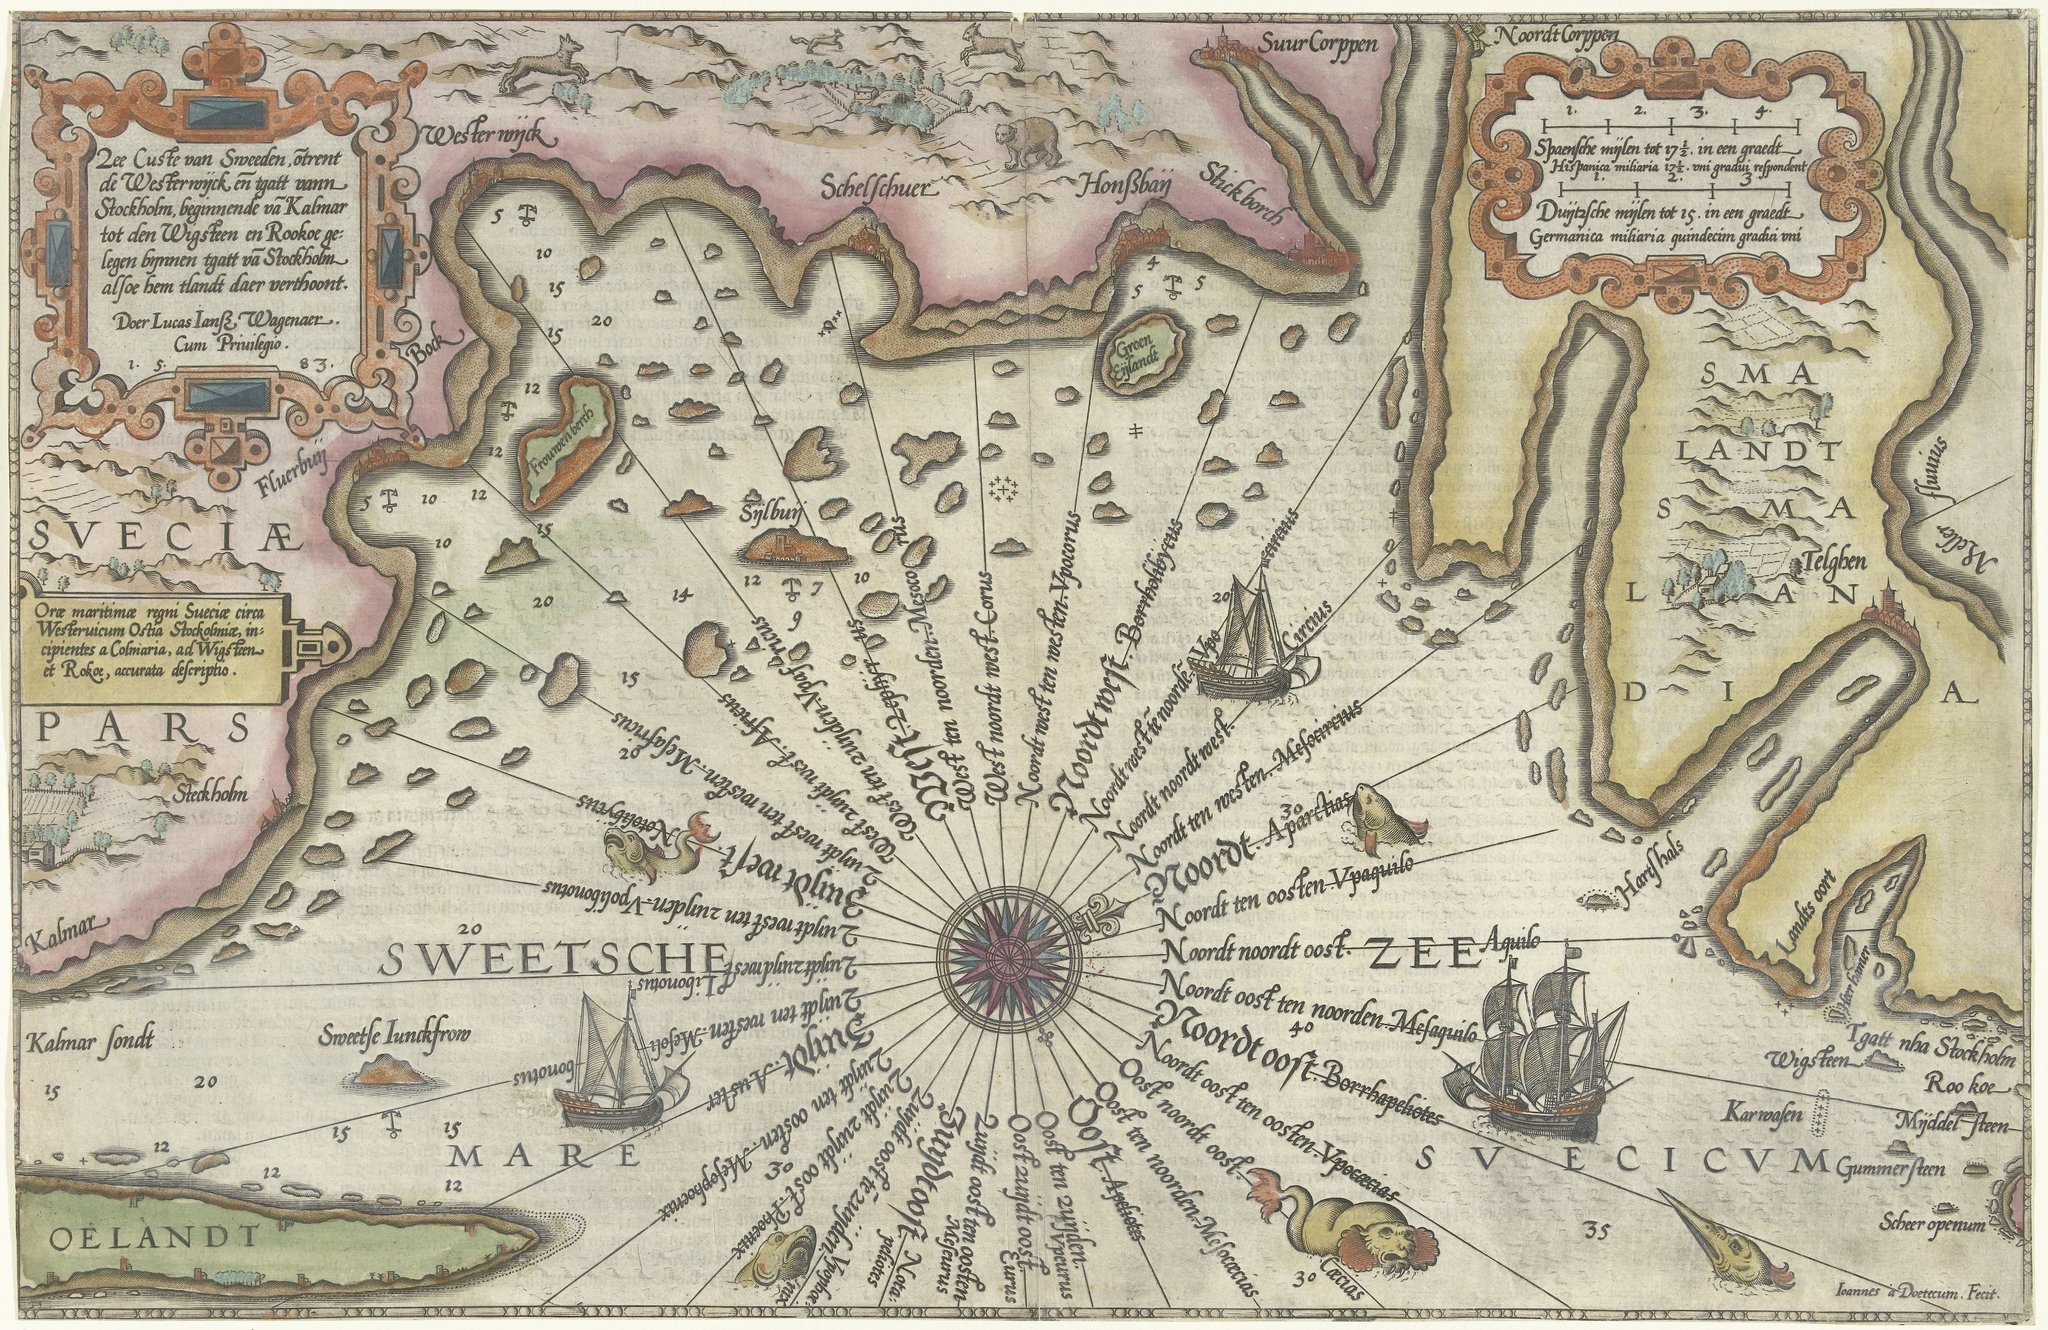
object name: print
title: Kaart van de kust van Zweden tussen Kalmar en Stockholm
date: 1580-1583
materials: paper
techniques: engraving, hand coloring, letterpress printing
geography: netherlands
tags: representation of last judgement, with the archangel michael weighing the souls (or dividing the blessed and the damned)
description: Kaart van de kust van Zweden tussen Kalmar en Stockholm. In het midden een windroos. Bladzijde uit een boek met tekst en een kaart van het eiland Gotland op het verso.